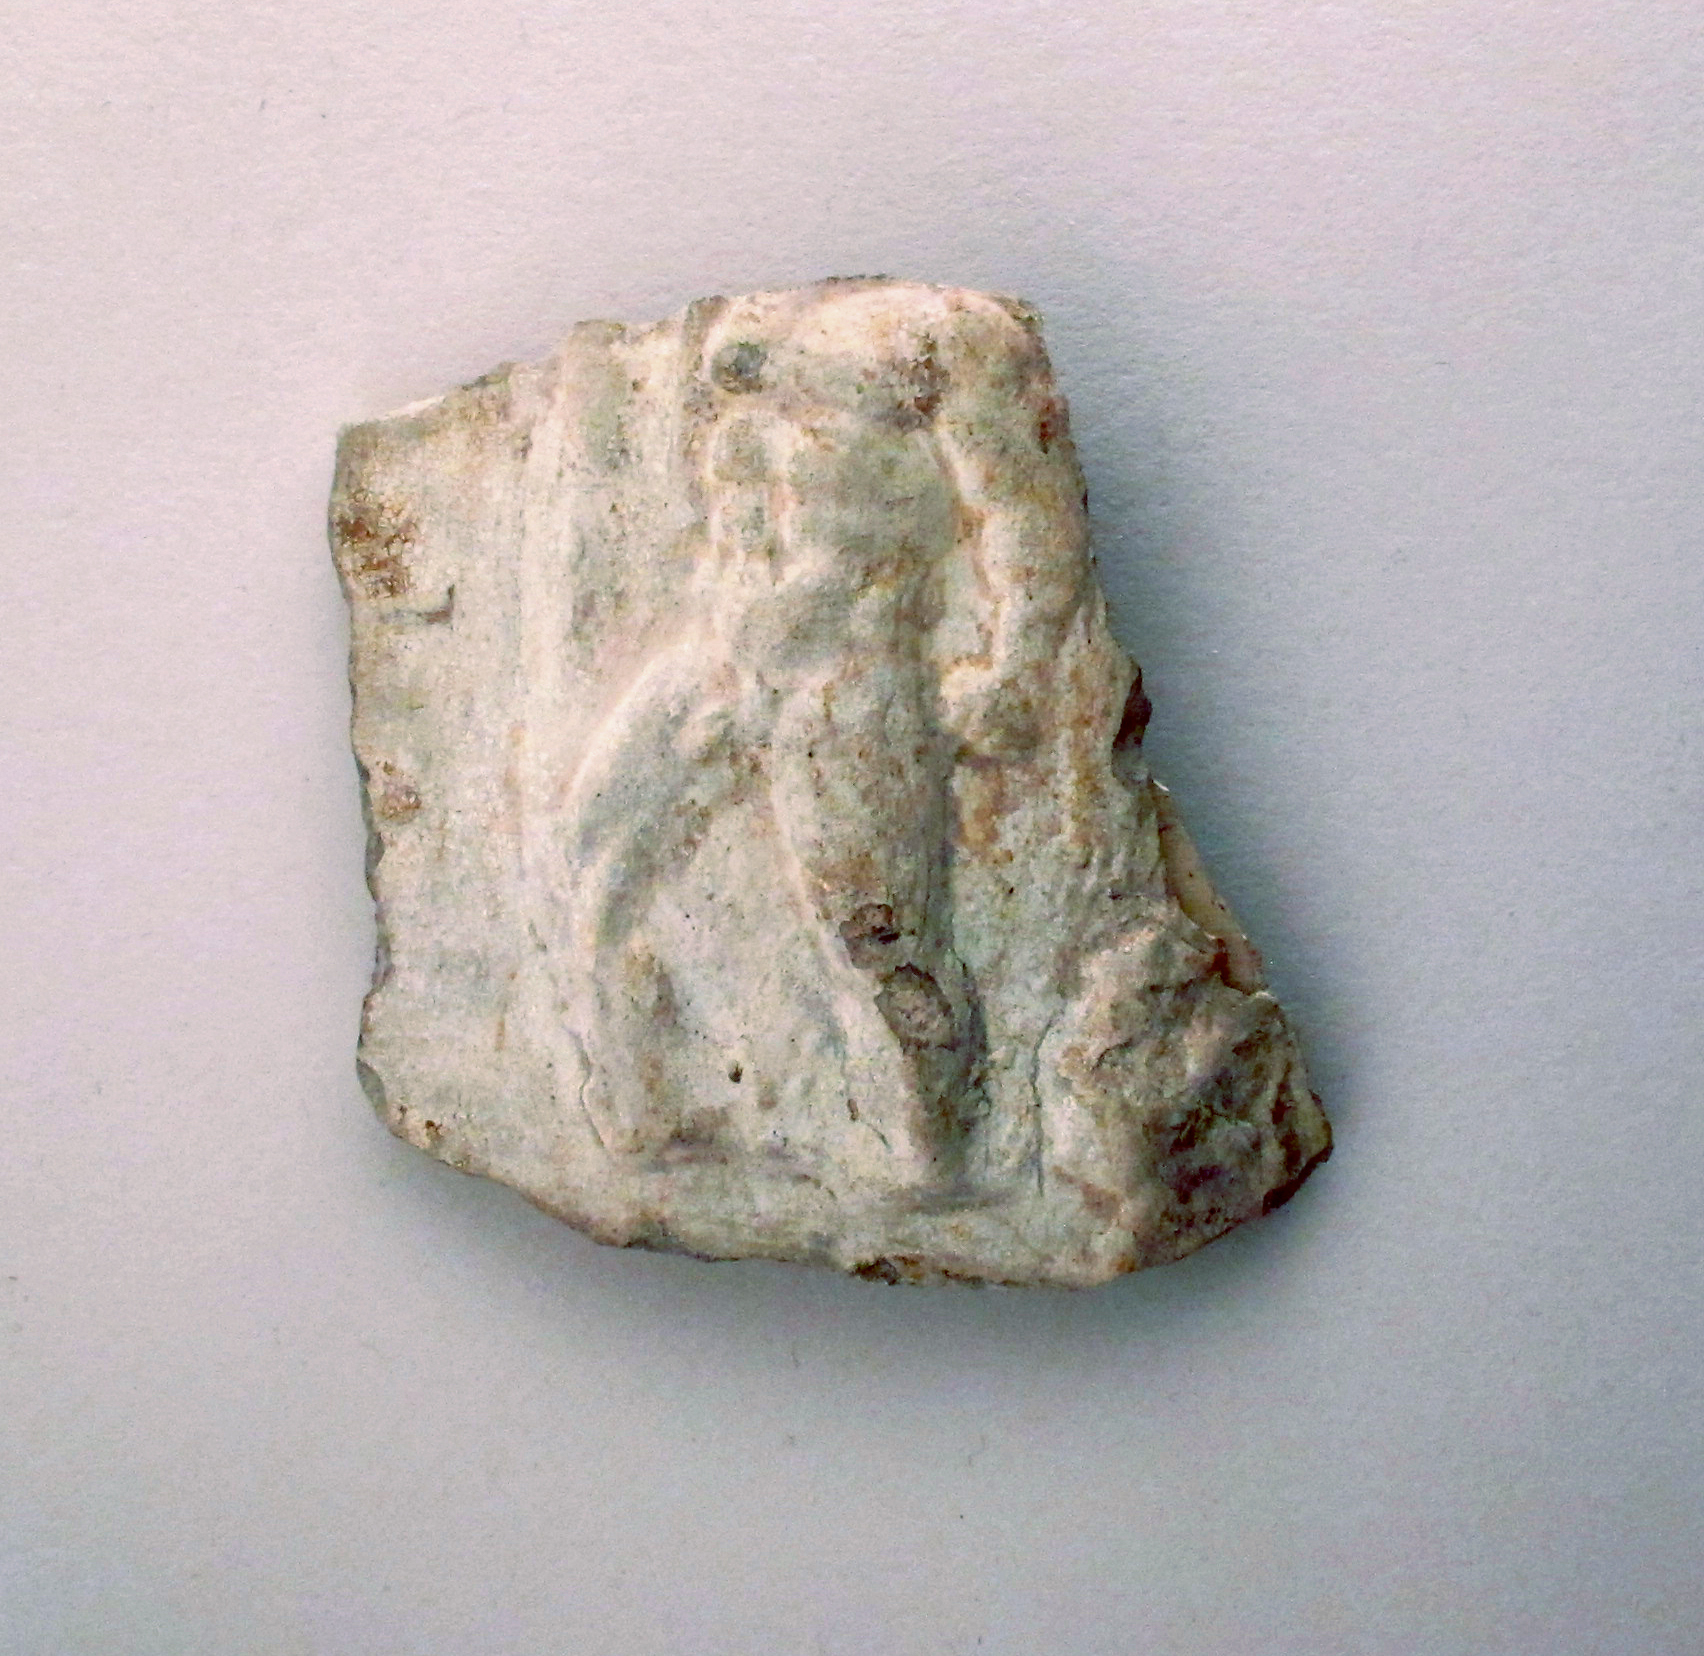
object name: vase fragment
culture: roman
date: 670 BCE-330 CE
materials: terracotta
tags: male nudes